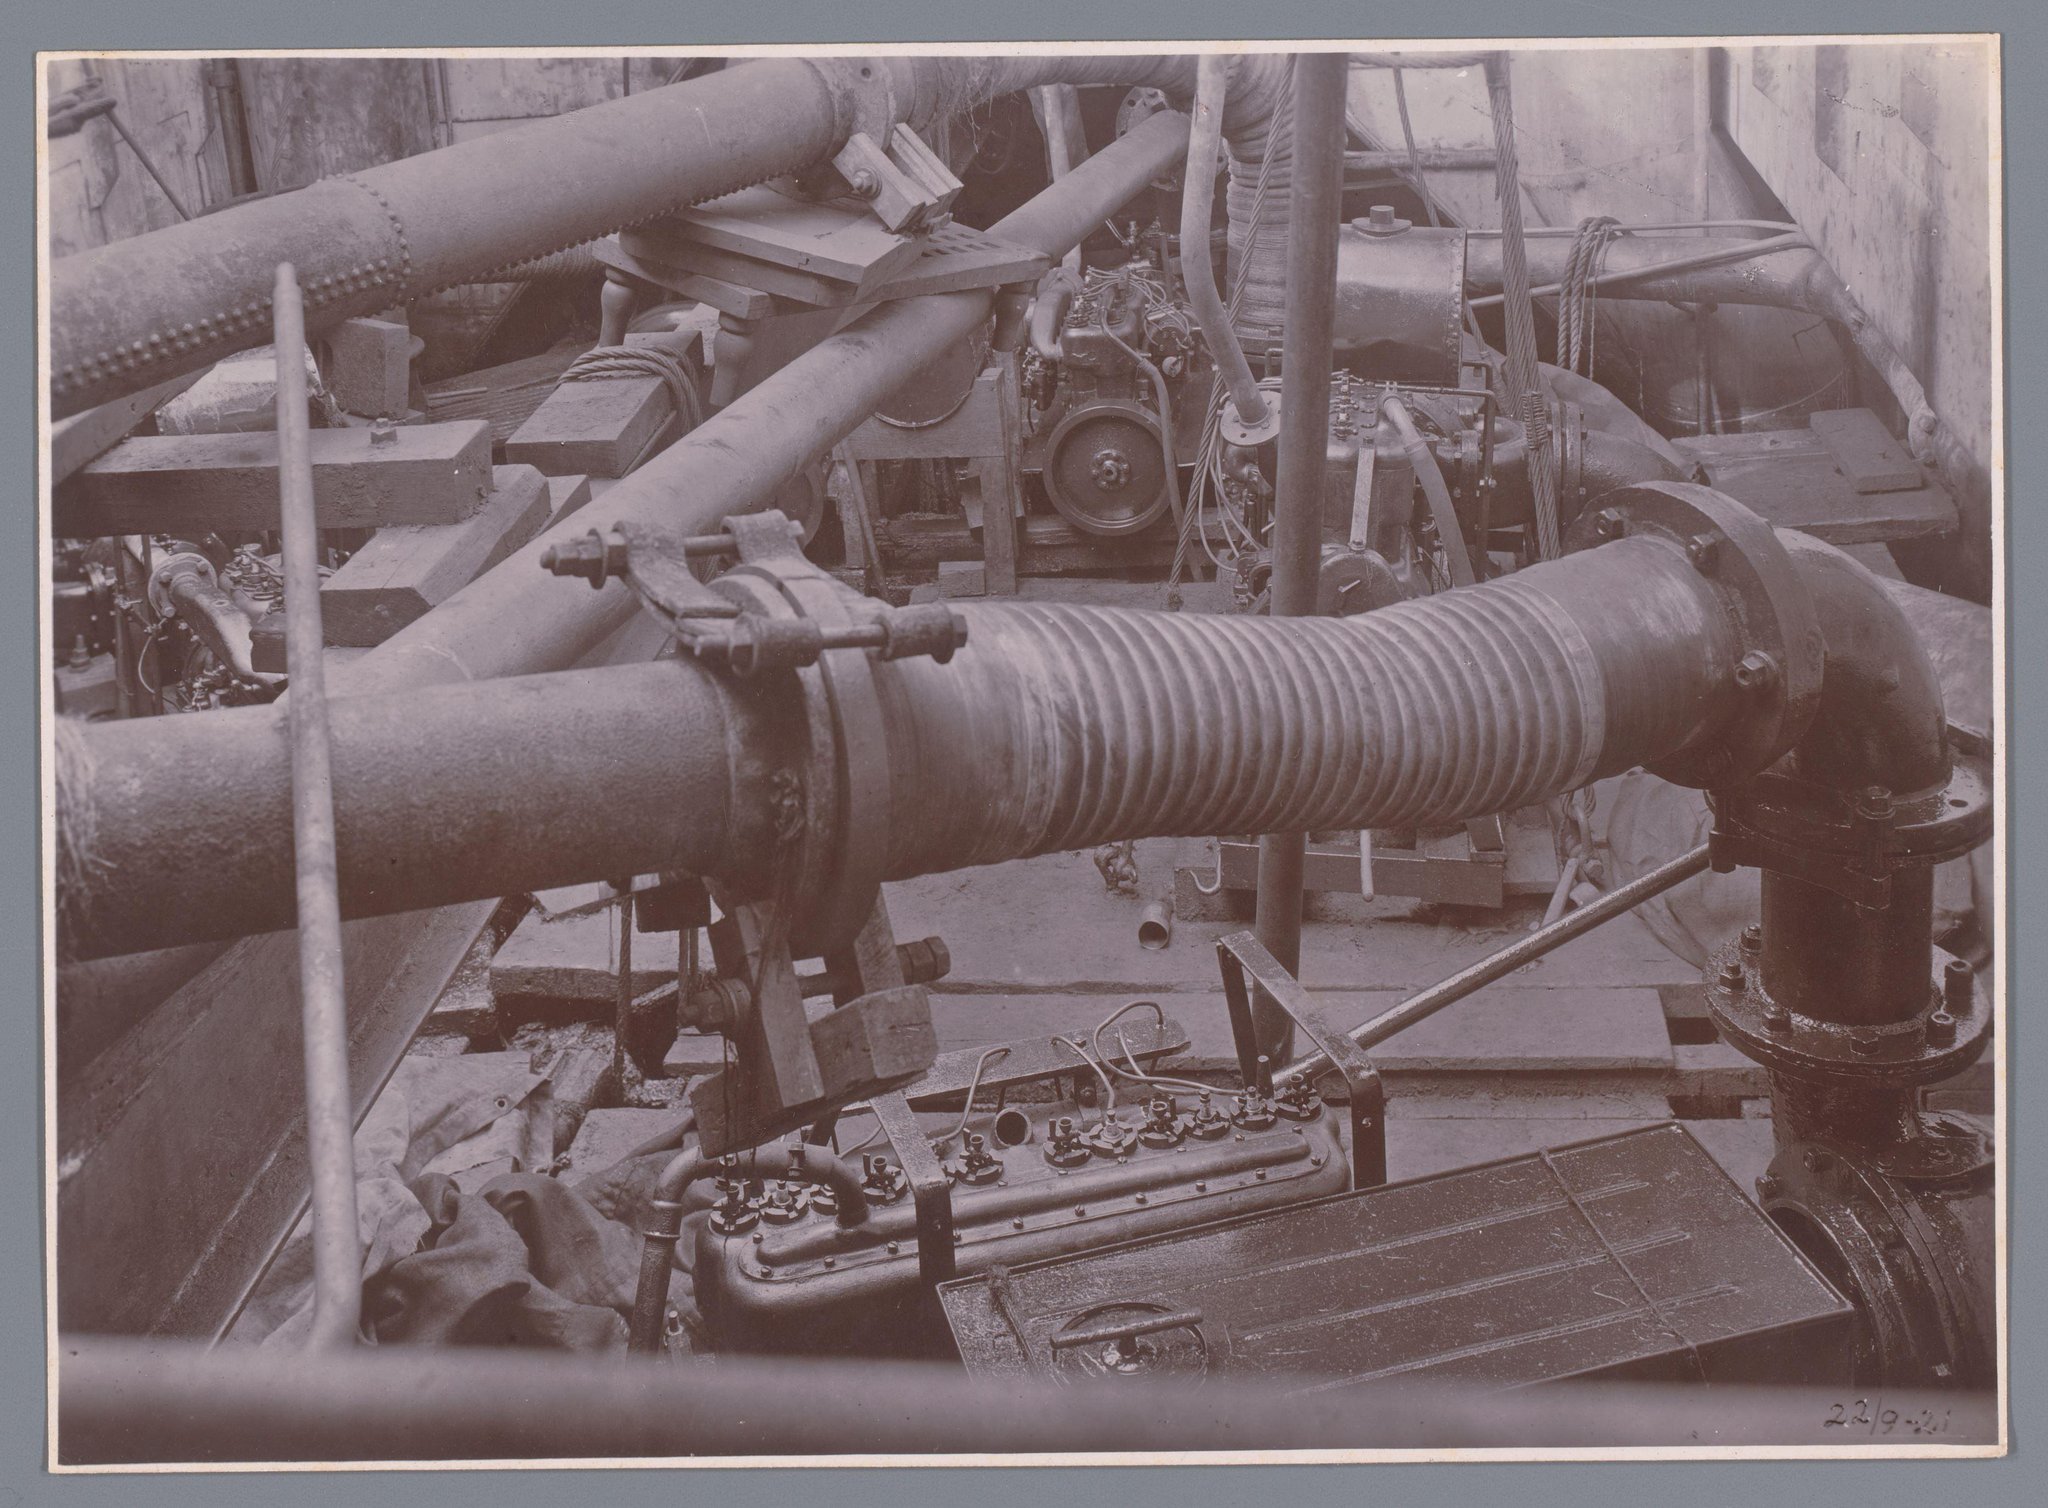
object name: photograph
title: Opname van S.S. Altenburg te Singapore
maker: Anonymous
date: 1921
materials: photographic support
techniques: gelatin silver print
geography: singapore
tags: steamsailer, singapore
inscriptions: inscription: ‘No. 75 / Opname van S S Altenburg te Singapore’, date: ‘22/9-21’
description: Machinerie aan boord van de S.S. Altenburg in Singapore. Genummerd: 75. Onderdeel van de groep van losse foto's over de aanleg van de haven Belawan aan de kust voor Medan, Sumatra 1921-1922.